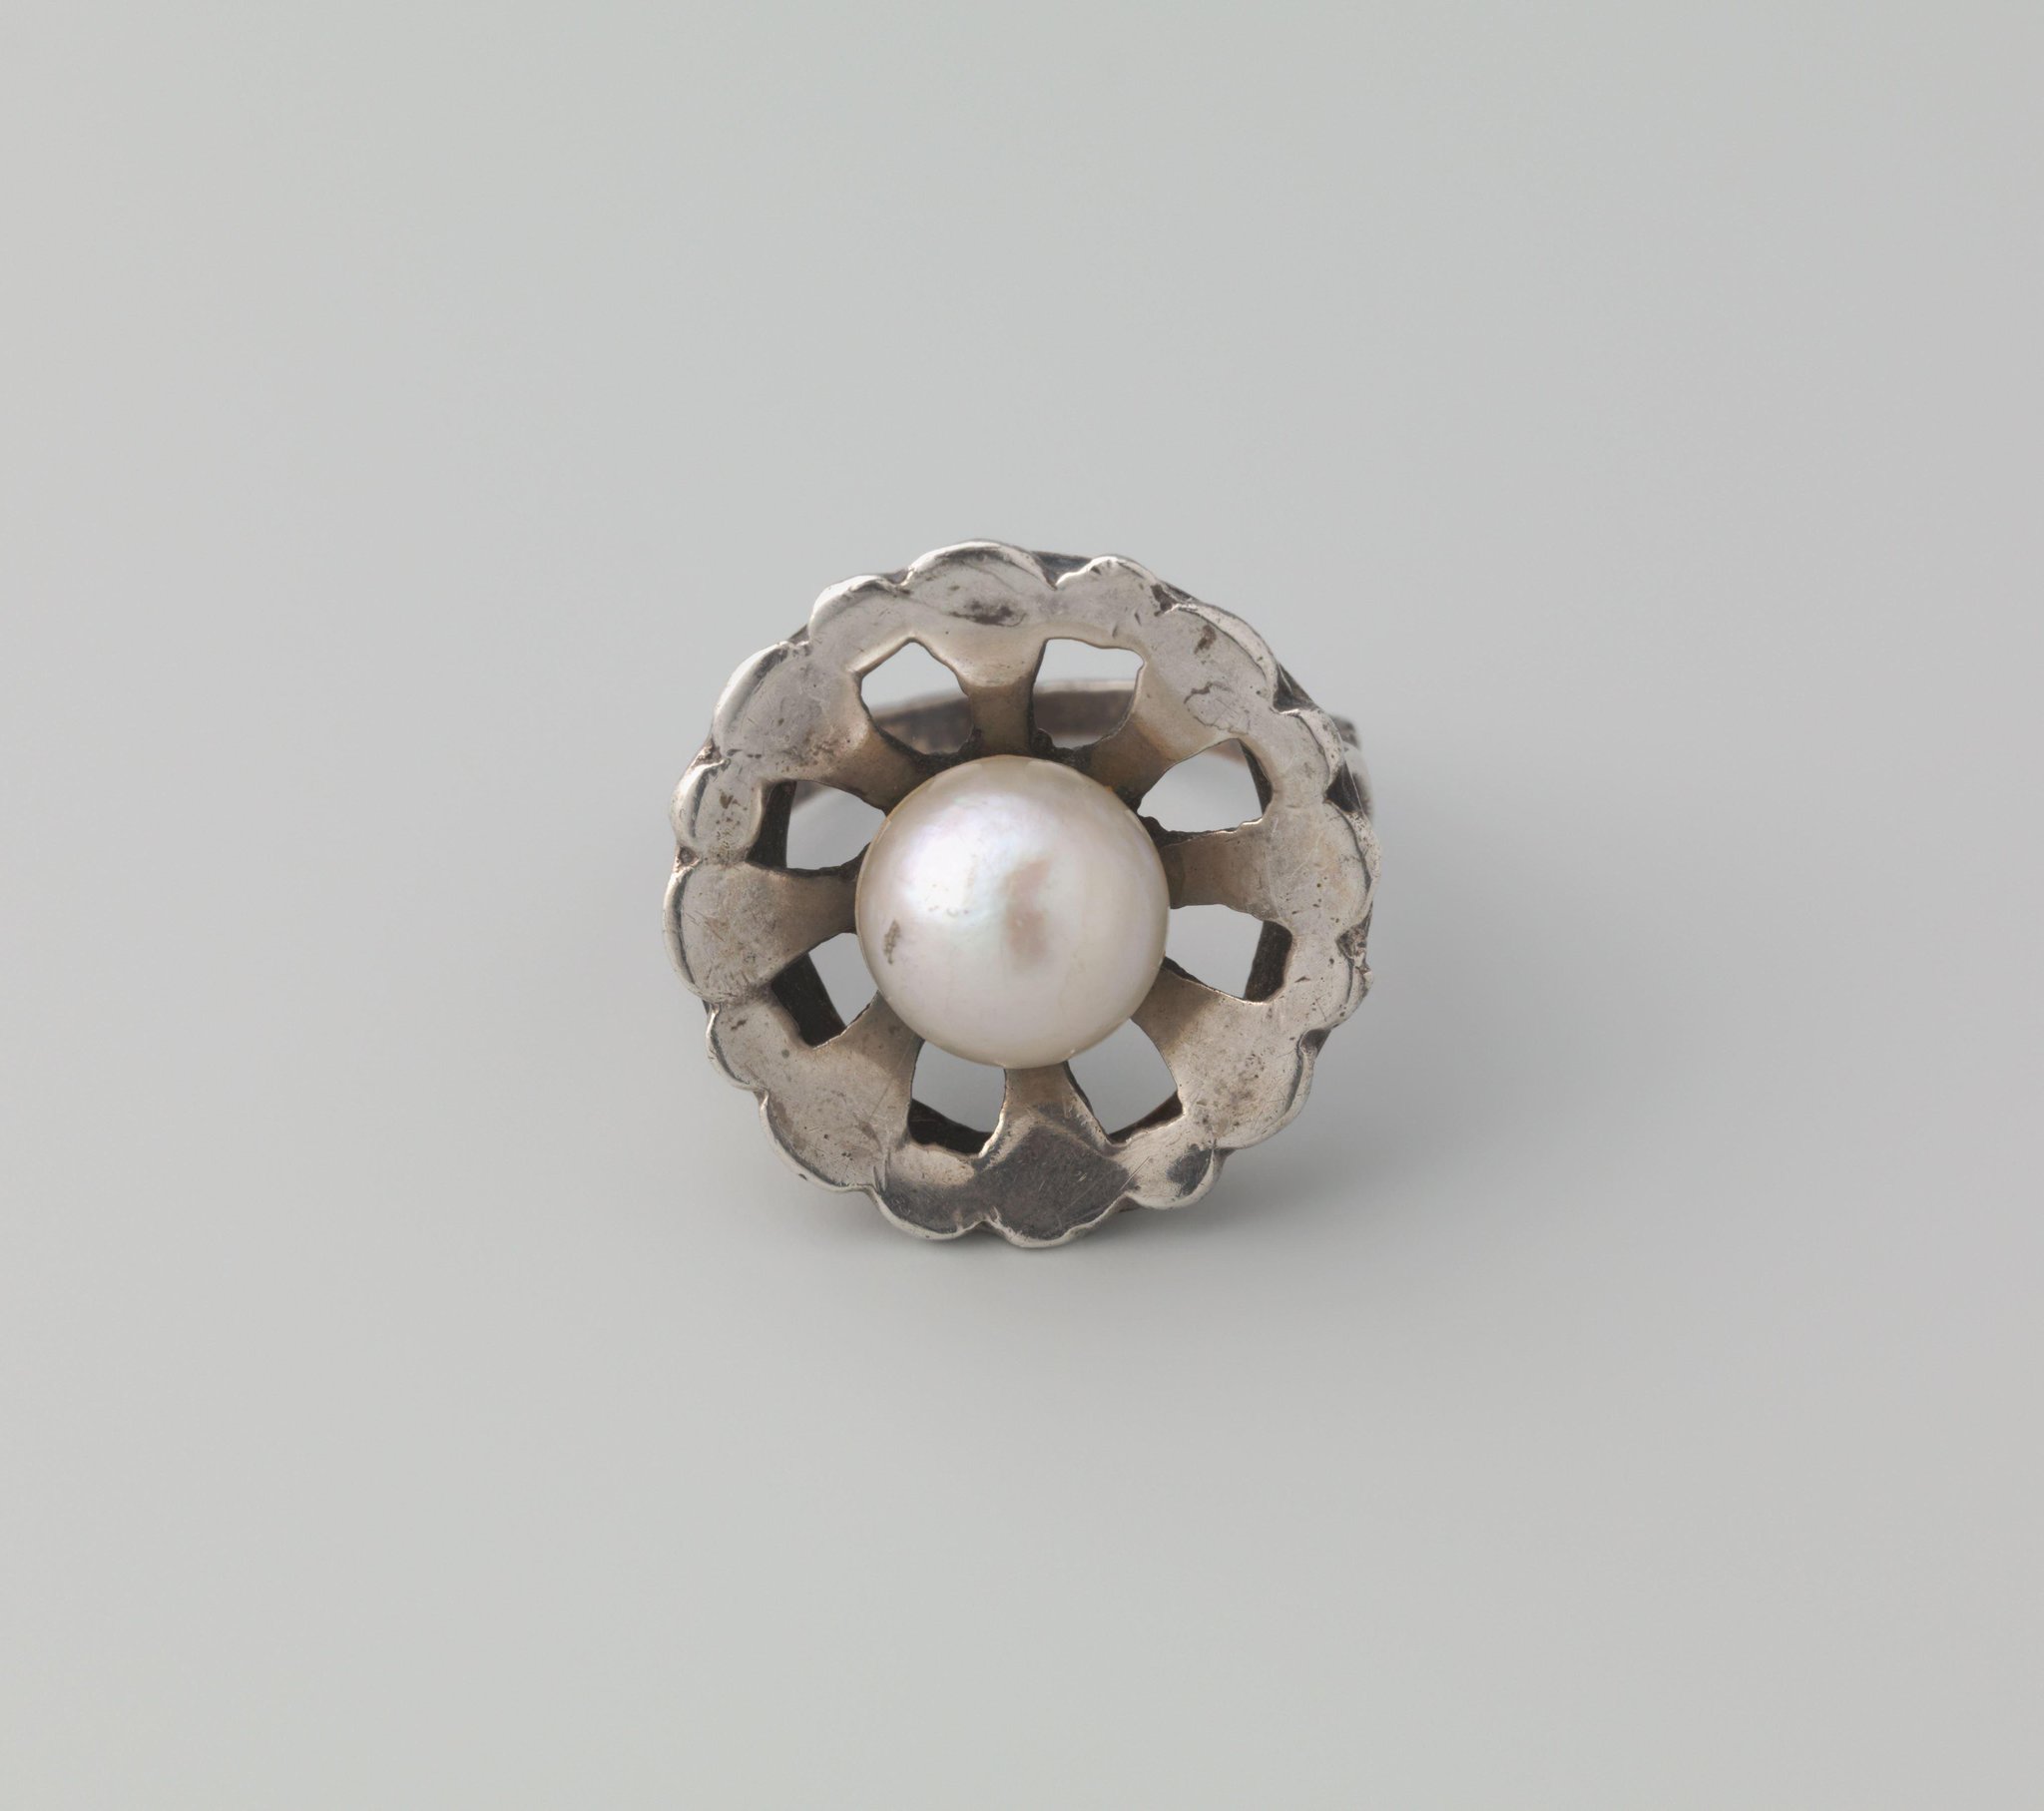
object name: ring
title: Tienerring van zilver met parel op opengewerkte knop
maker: Anonymous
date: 1960-1970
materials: pearl, silver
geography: amsterdam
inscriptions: : ‘I’, maker's mark: ‘CH6’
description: Tienerring van zilver met parel op opengewerkte knop. De rand van de ring is geschulpt.